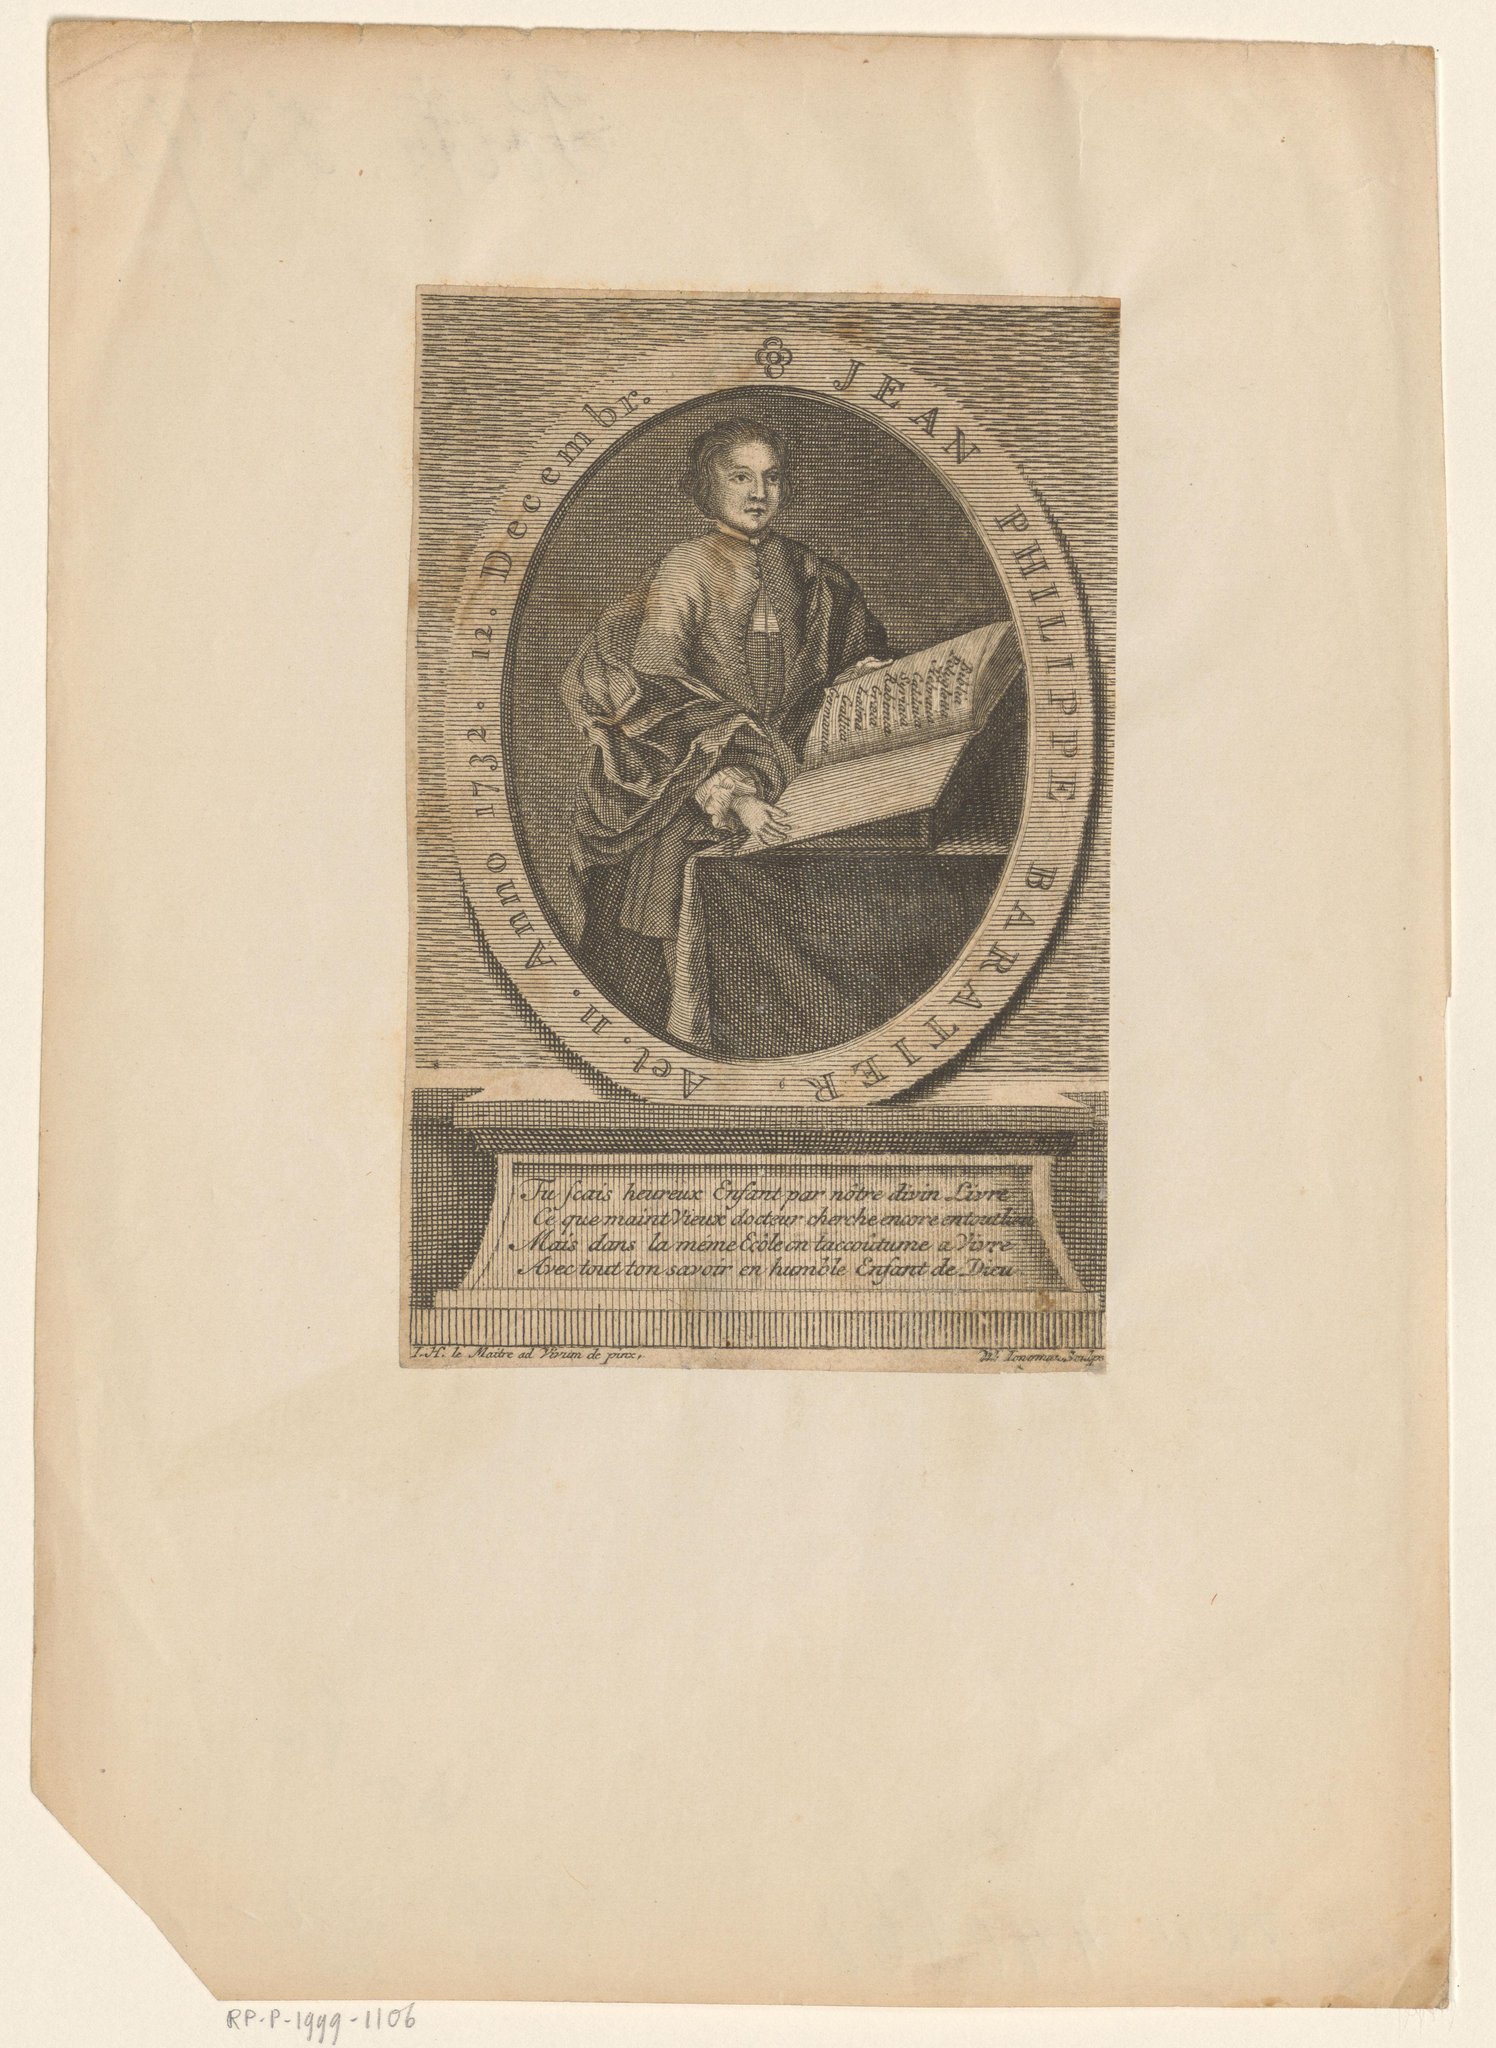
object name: print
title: Portret van Jean-Philippe Baratier op 11-jarige leeftijd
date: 1732-1749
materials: paper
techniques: engraving, etching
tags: historical persons, book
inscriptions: collector's mark: Lugt 2228